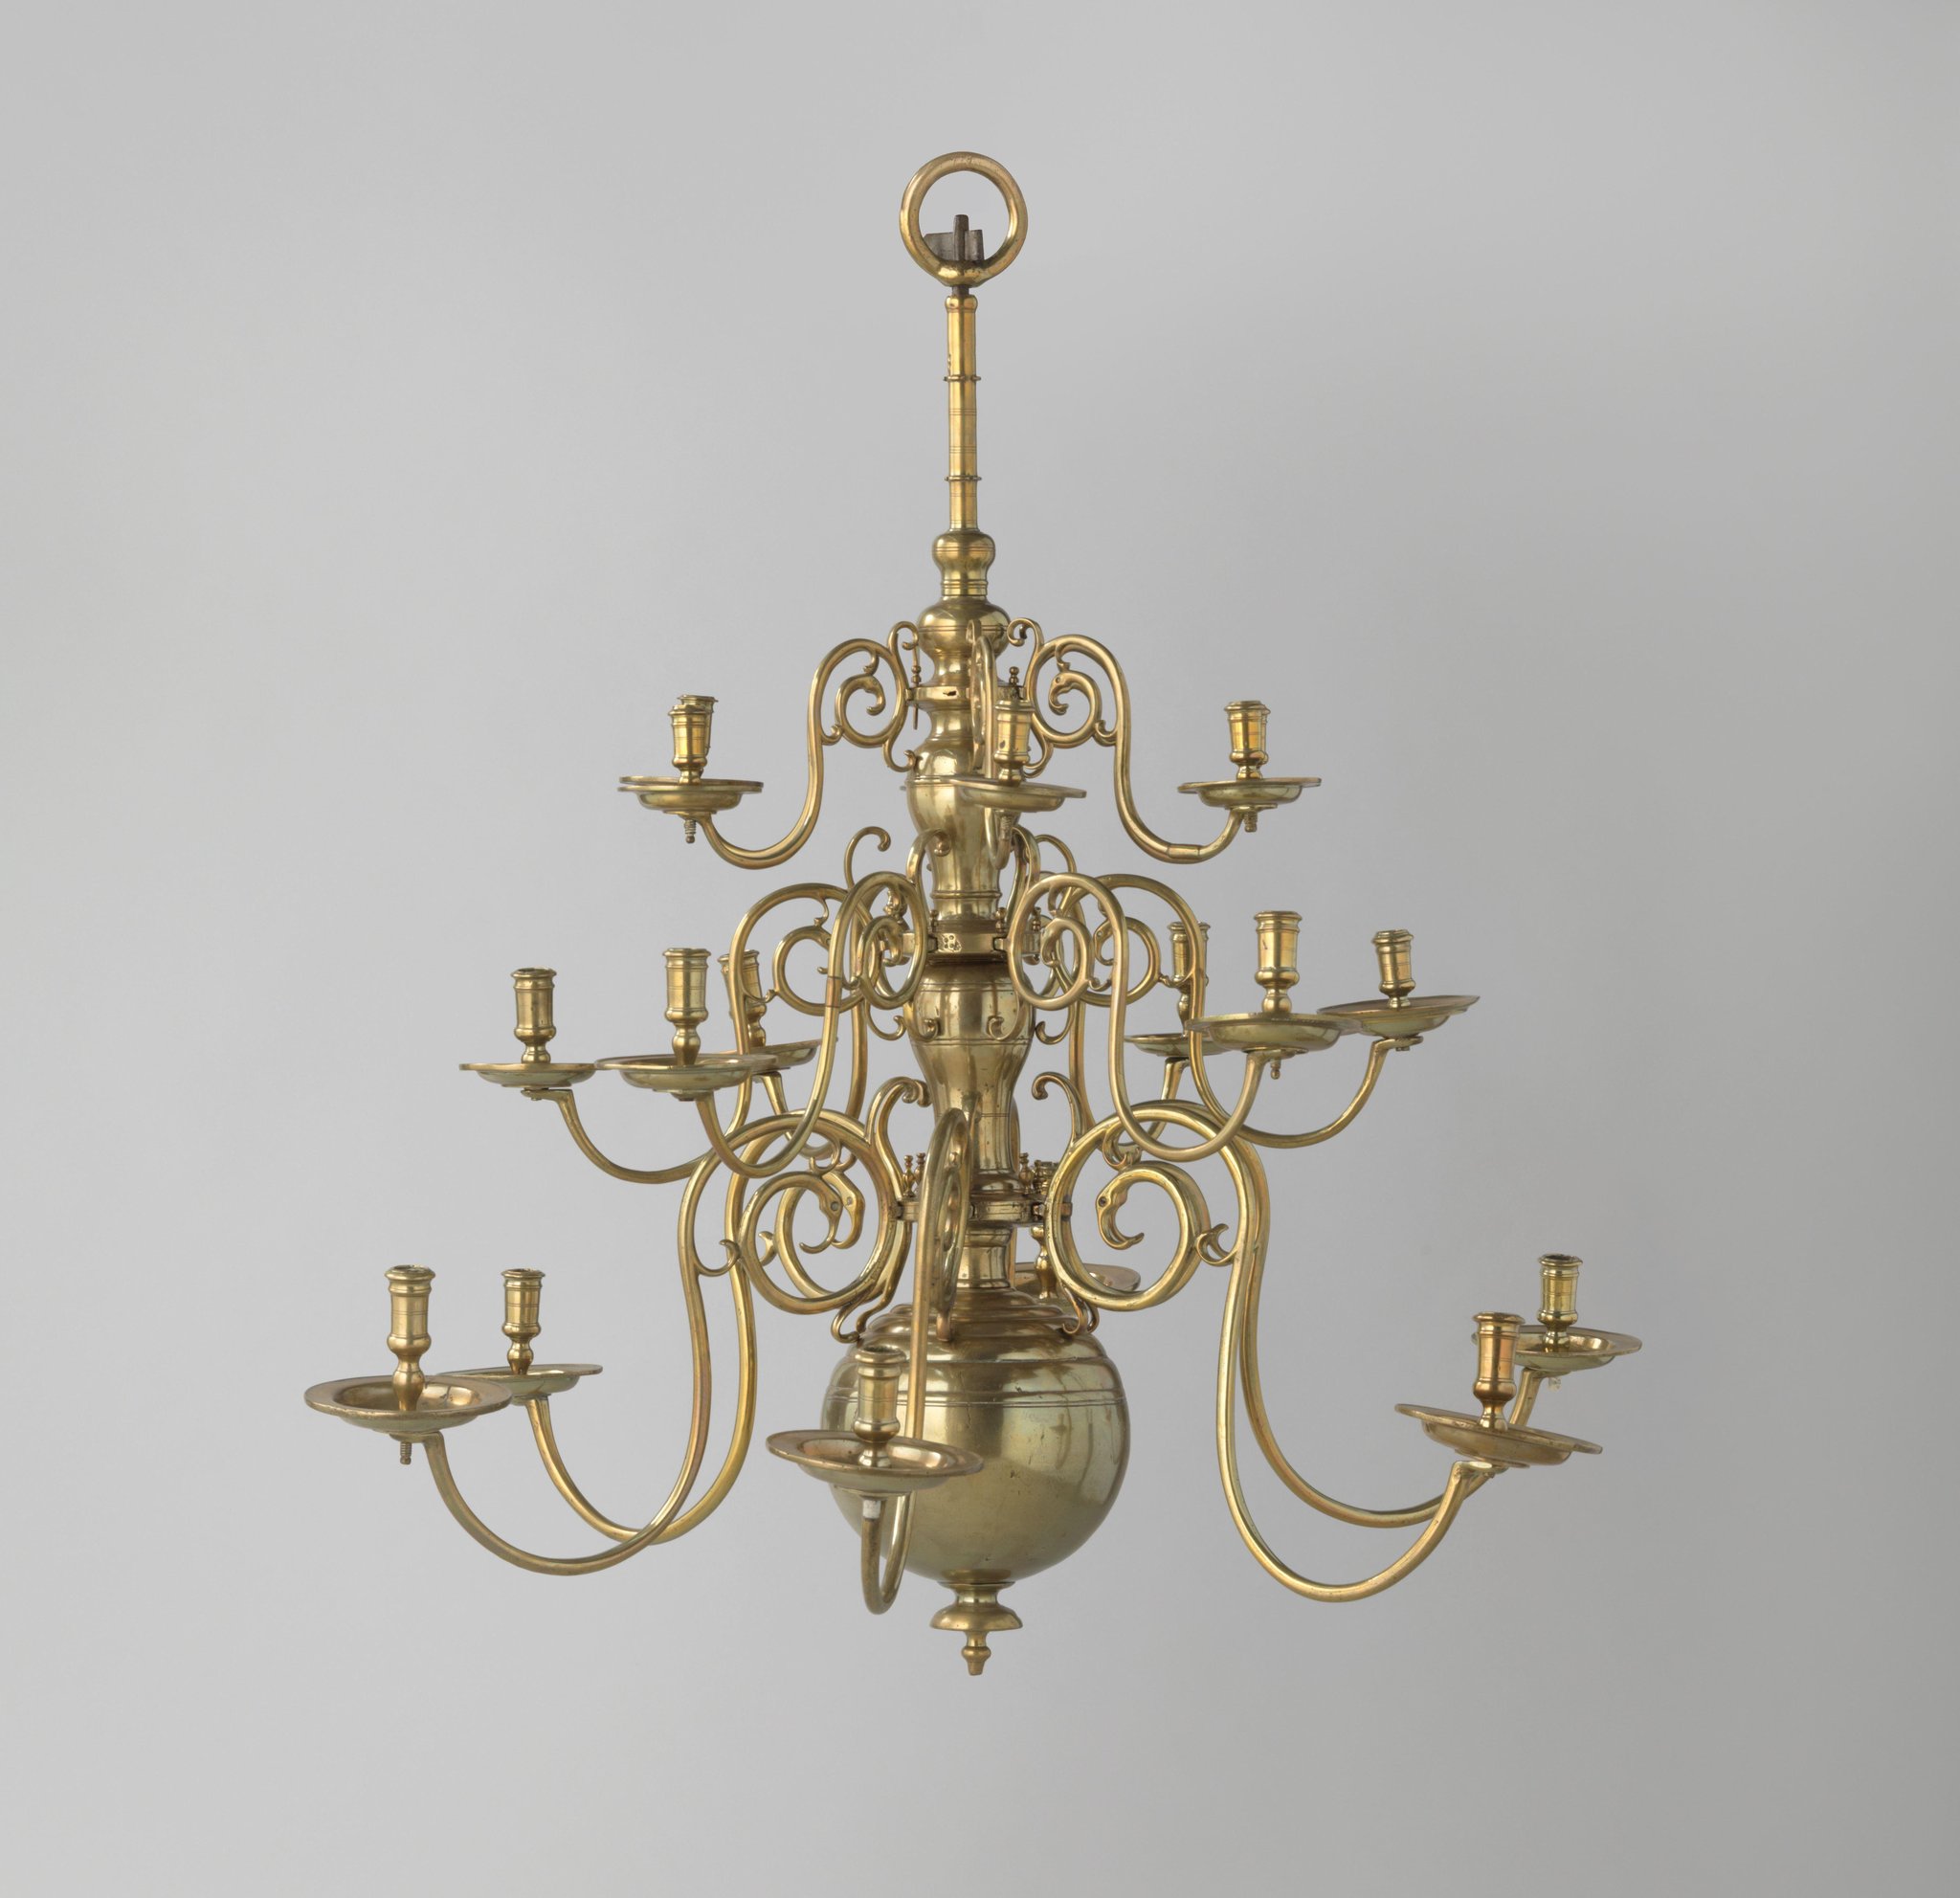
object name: chandelier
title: Arm met kaarsenhouder van kaarsenkroon van drie hoogten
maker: Anonymous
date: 1675-1725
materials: brass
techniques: casting, screwed, turning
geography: southern netherlands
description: Kaarsenarm behorende bij een messing kaarsenkroon van drie hoogten. De S-vormige arm heeft een krul en gaat naar buiten toe over in het platte verdikking met een schroefgat. Daarin is de kaarsenhouder met de vetvanger vastgezet. De vetvanger is aan de onderzijde geribd geprofileerd rond de opening en heeft verder twee gegroefde ringen. De cylindrische kaarsenhouder, die een geprofileerde uitstekende rand, twee gegroefde ringen en een verdikking onderaan heeft, gaat over in een baluster met onderaan het eind met schroefdraad en een knopje, waarin het centergat te zien is. Dit is de derde arm van de middelste standring, genummerd met 3 ronde punten. De pin, om de arm aan de standring te bevestigen, heeft bovenop een ronde knop.